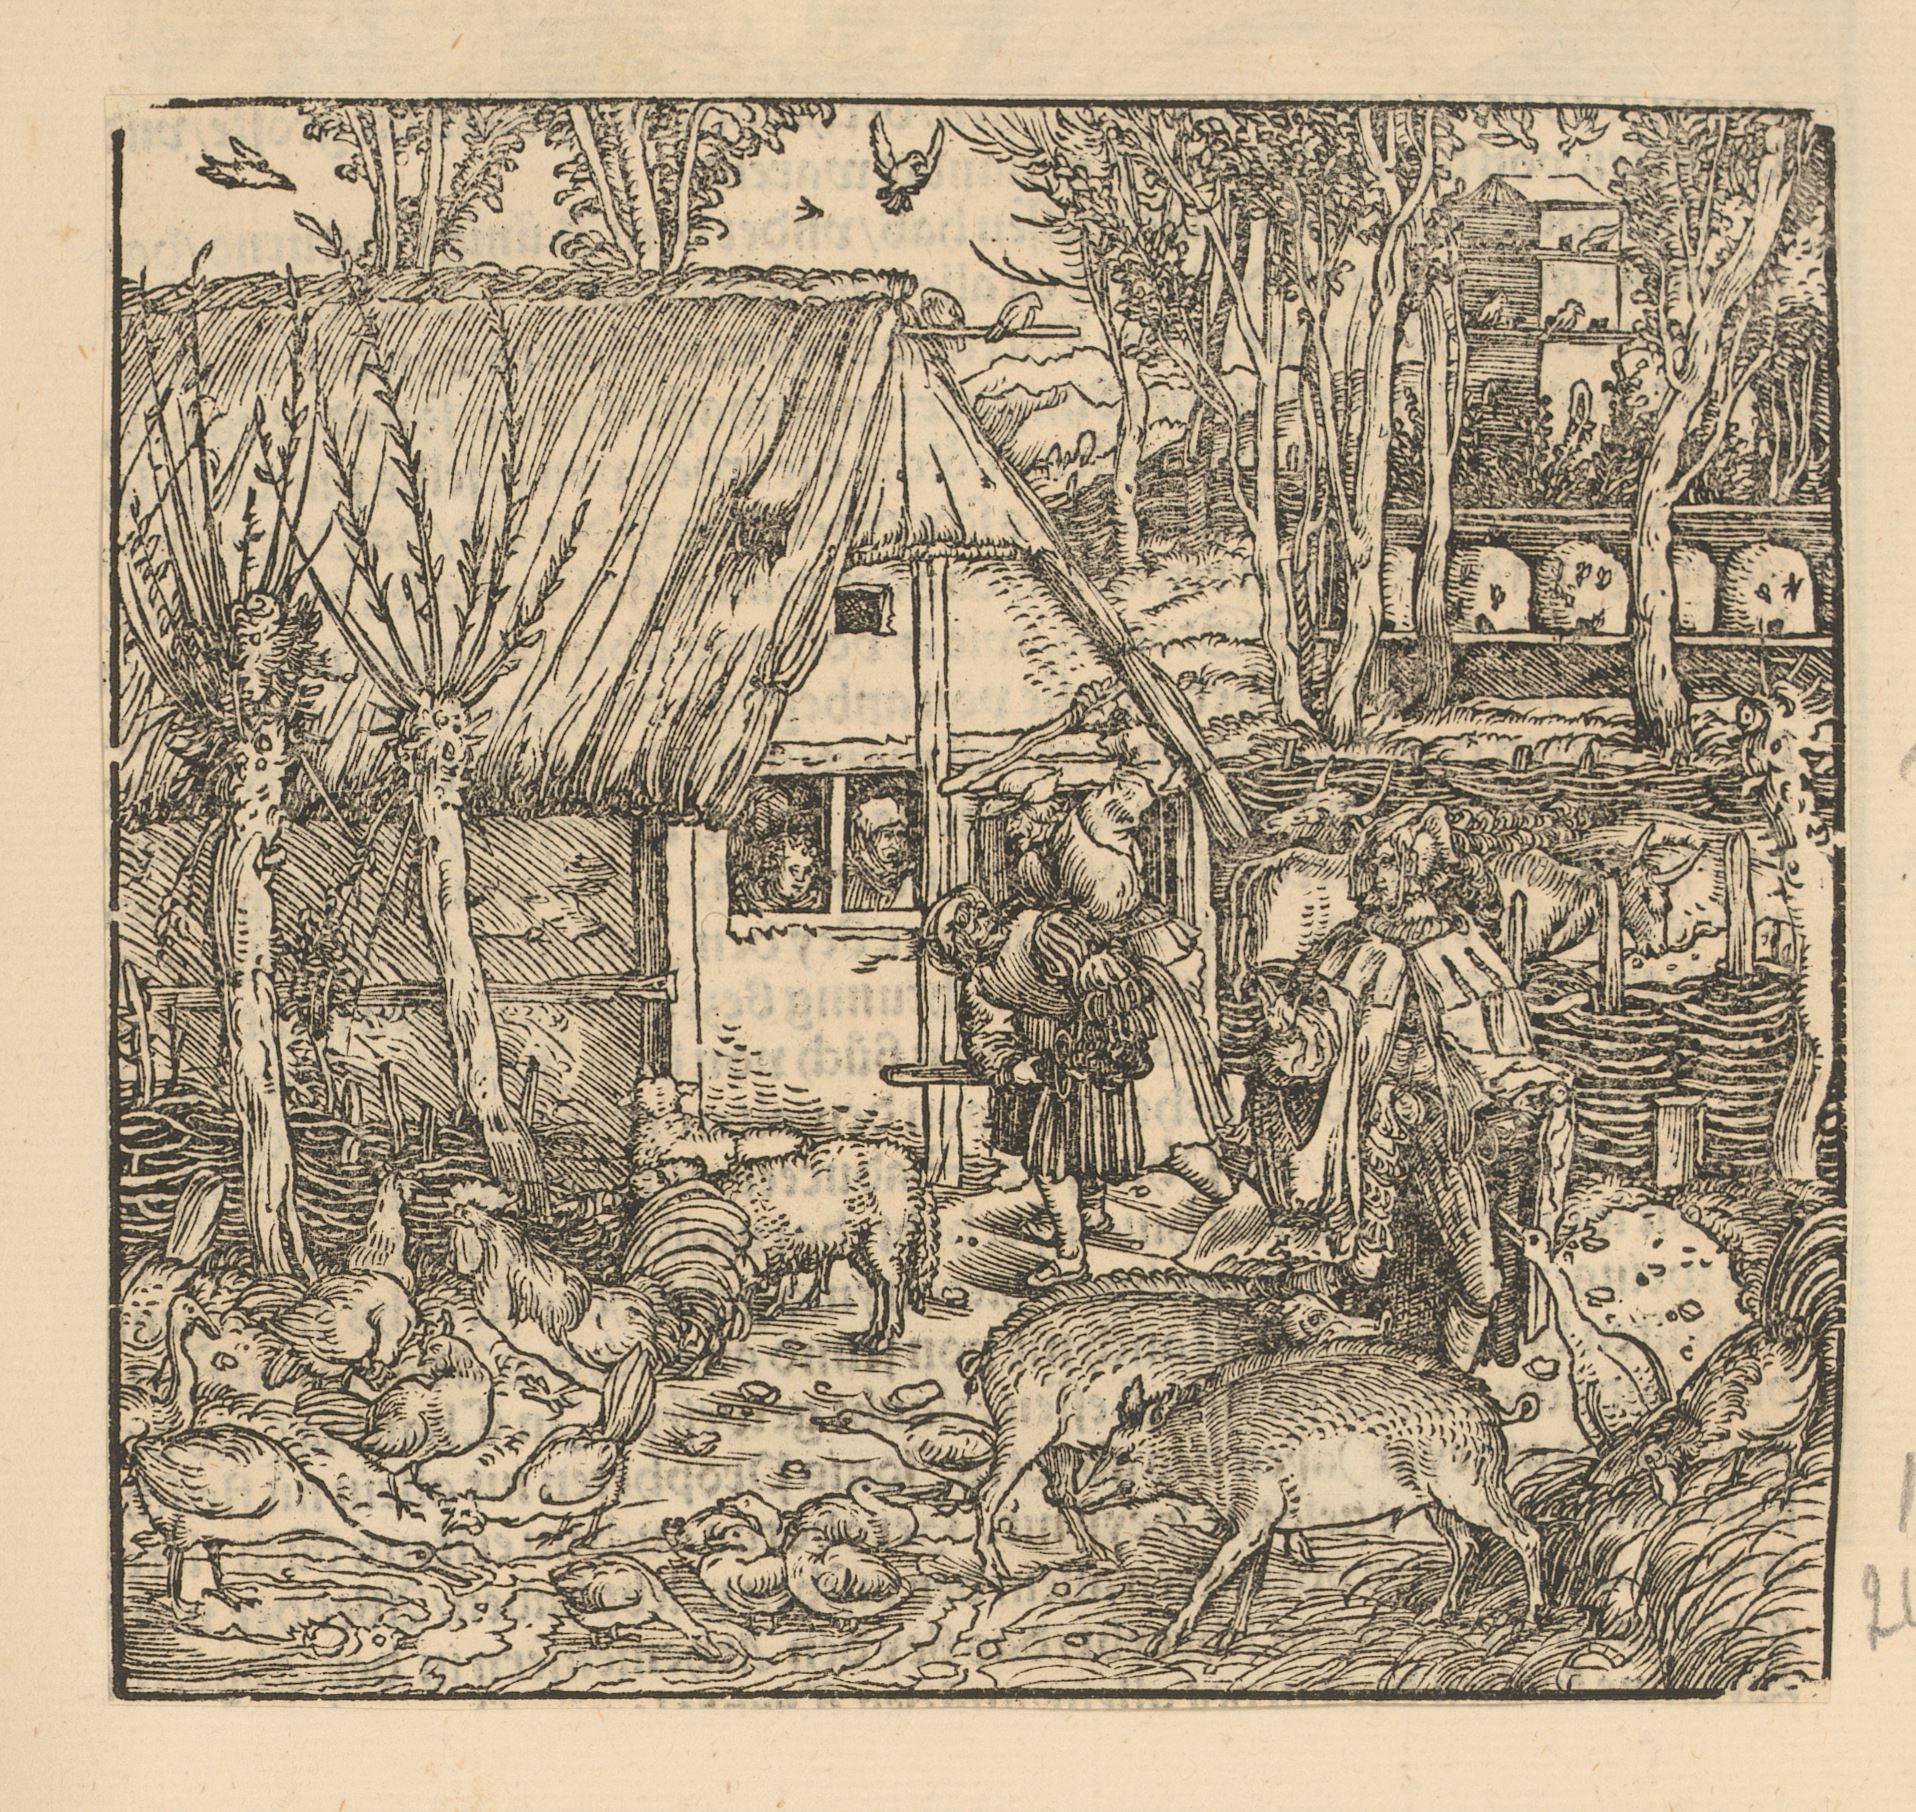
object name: print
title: Boer slaat een man op zijn erf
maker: Anonymous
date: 1514-1532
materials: paper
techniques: letterpress printing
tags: fight between farmers and soldiers, farm or solitary house in landscape, cattle-breeding, livestock industry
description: Deze prent is gebruikt in: Petrarca, Francesco. Von der Artzney bayder Glück, des guten und widerwertigen: unnd weß sich ain yeder inn Gelück und Unglück halten sol (...). Augsburg: Heinrich Steiner, 1532. Deze uitgave is ook bekend onder de titel 'Trostspiegel in Glück und Unglück'.